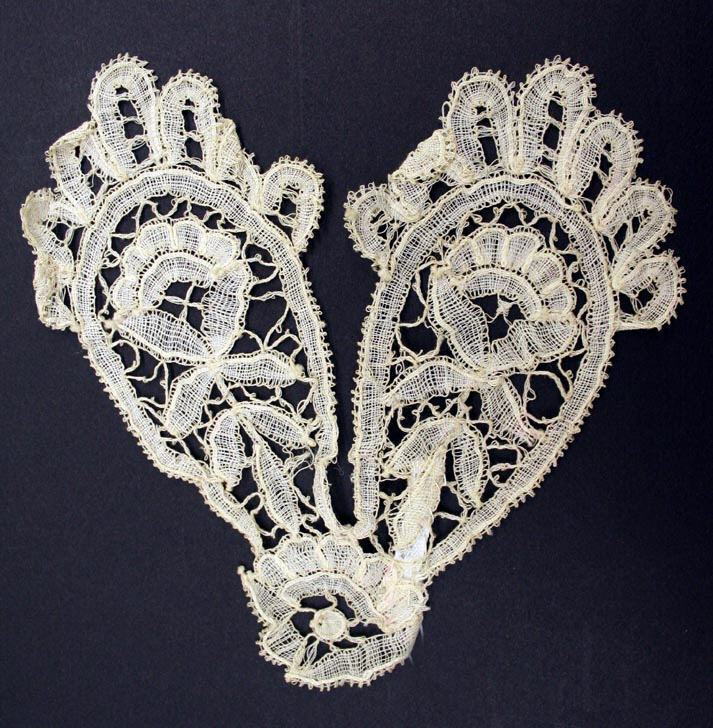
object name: jabot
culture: american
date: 1860-1869